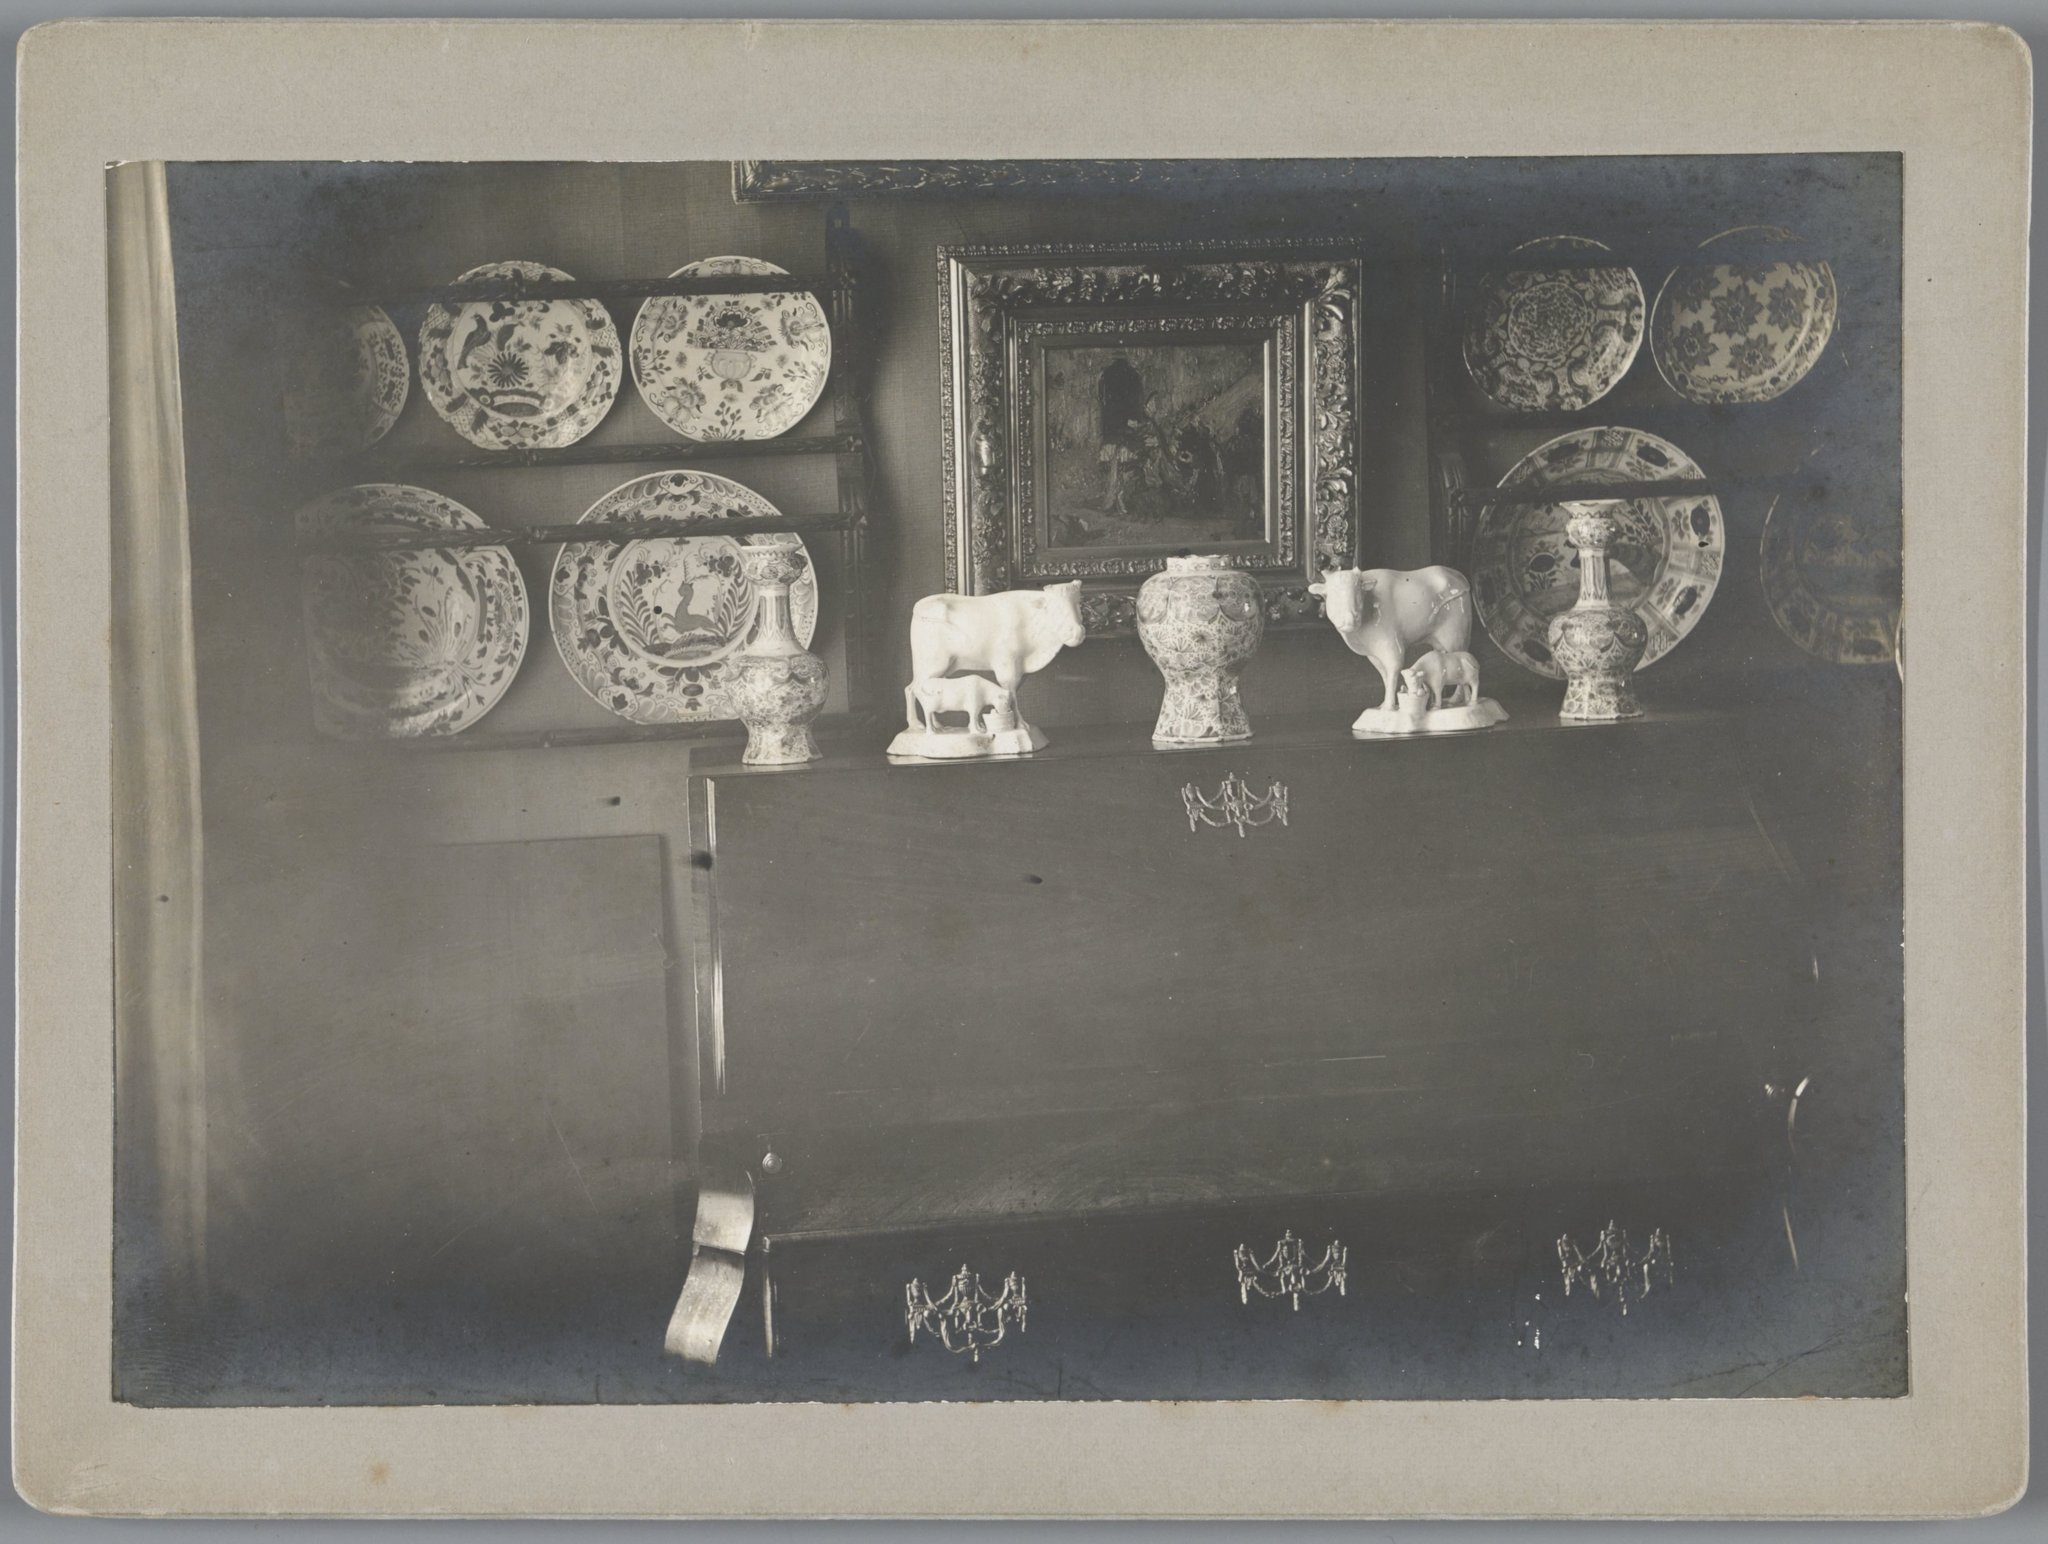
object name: photograph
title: Interieur Witsen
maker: willem witsen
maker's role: draughtsman, painter, print maker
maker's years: 1860-1923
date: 1860-1915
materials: paper, photographic support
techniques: gelatin silver print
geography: amsterdam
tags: witsenhuis